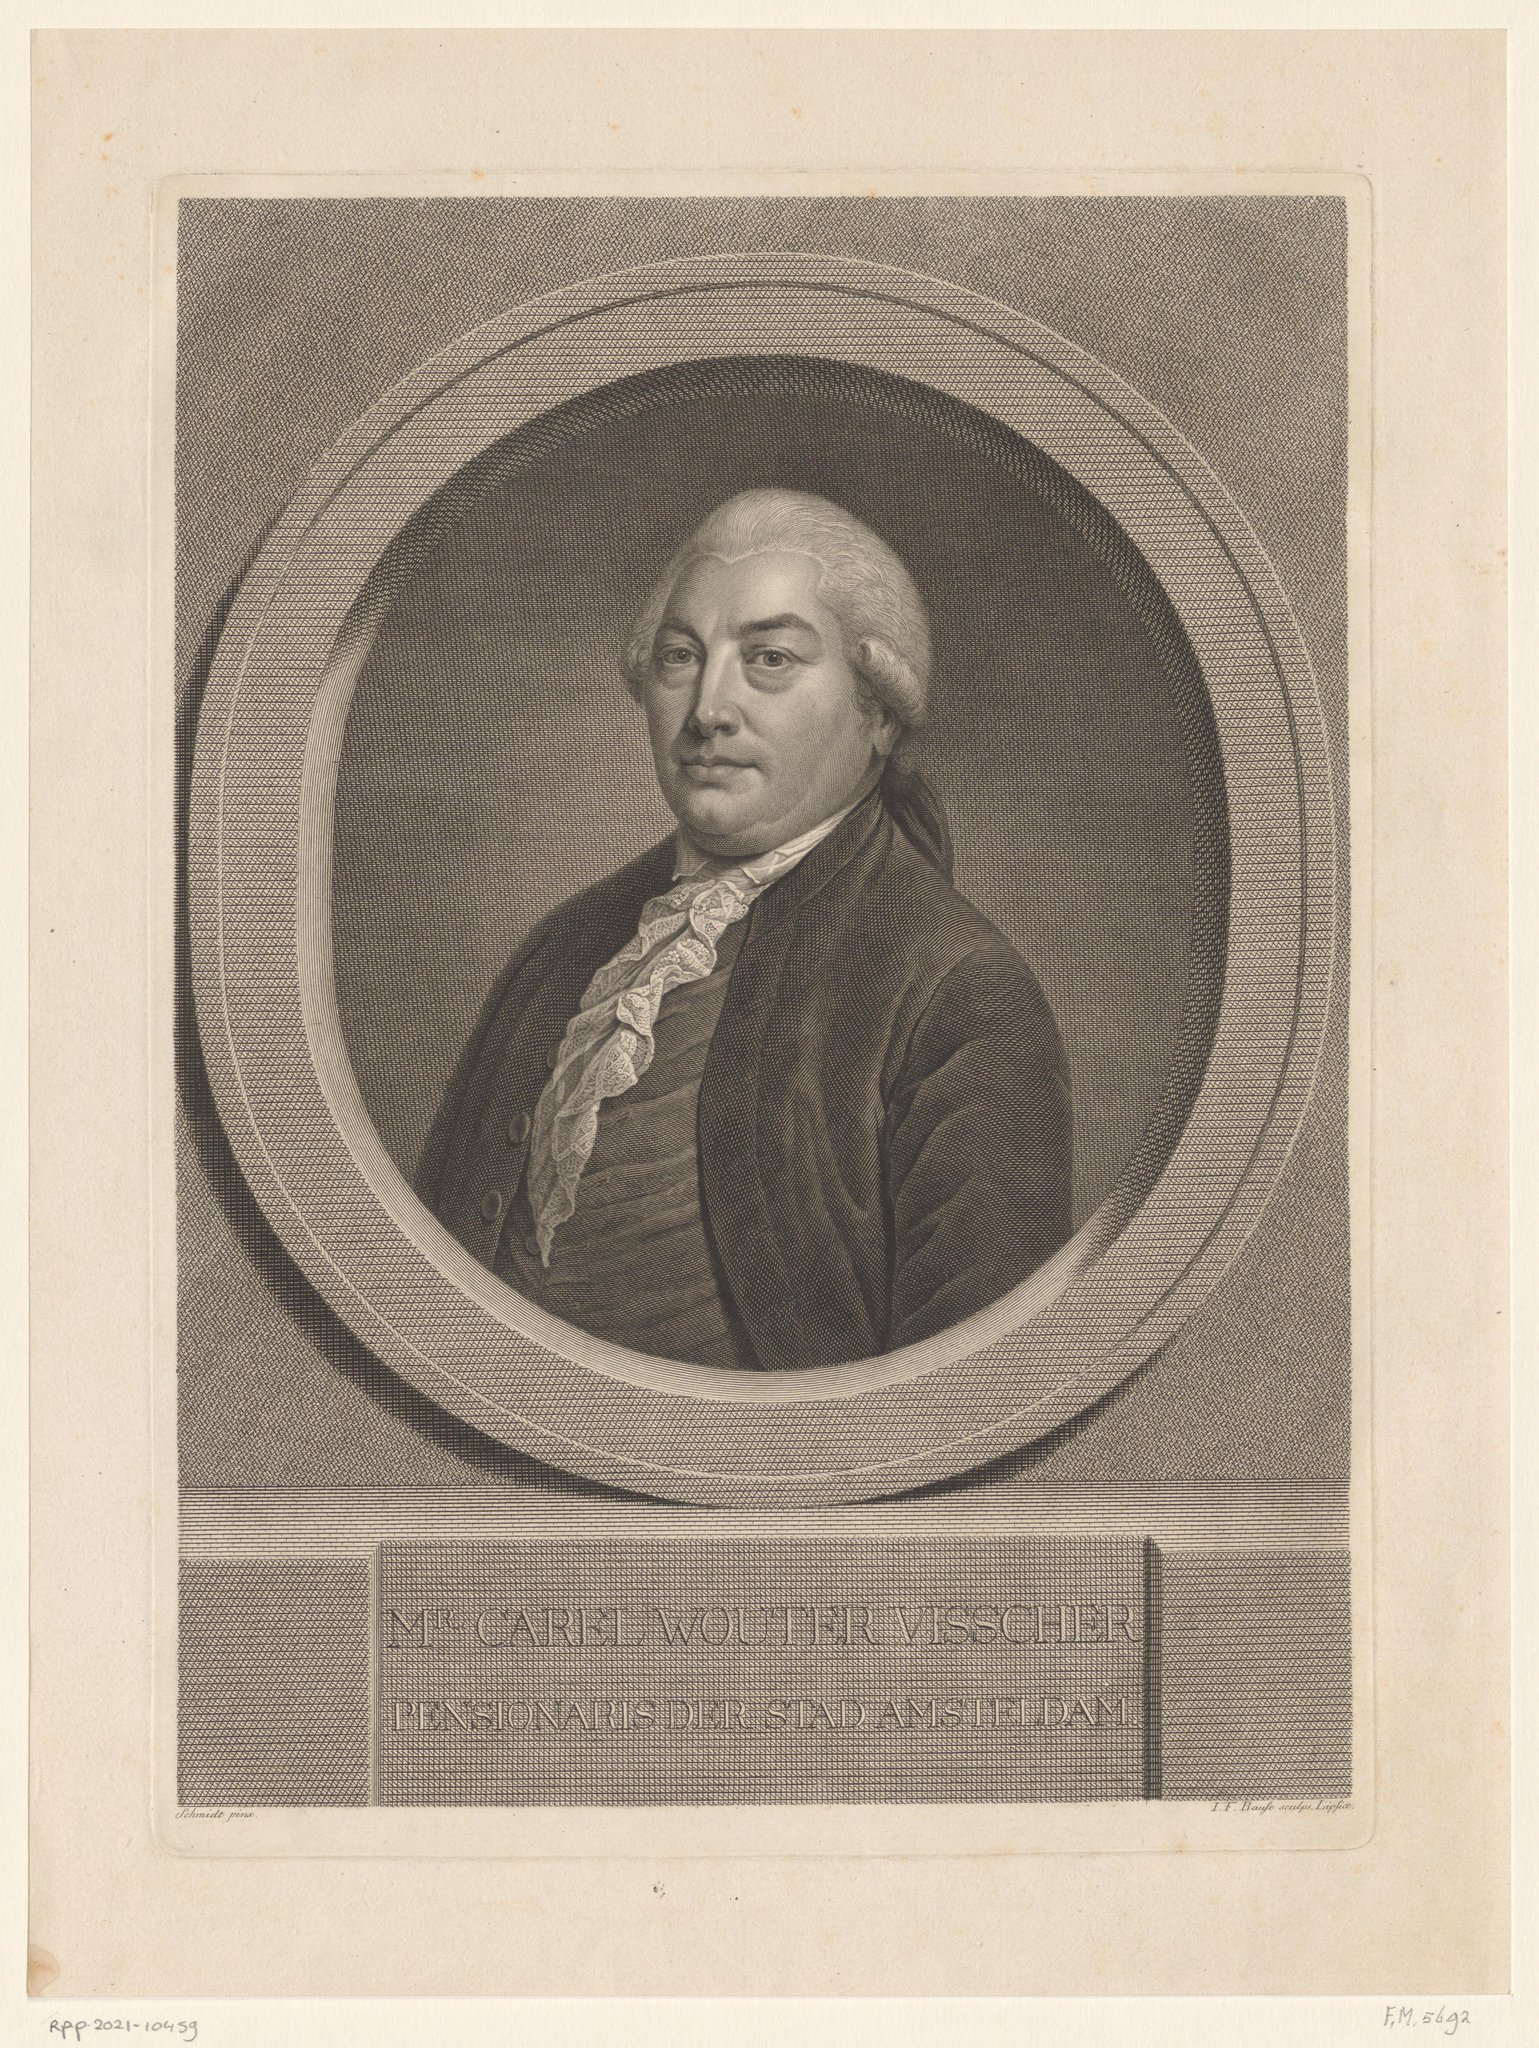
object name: print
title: Portret van Carel Wouter Visscher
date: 1786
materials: paper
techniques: engraving, etching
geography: leipzig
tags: adult man, historical persons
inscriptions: inscription, collector's mark: Lugt 2228